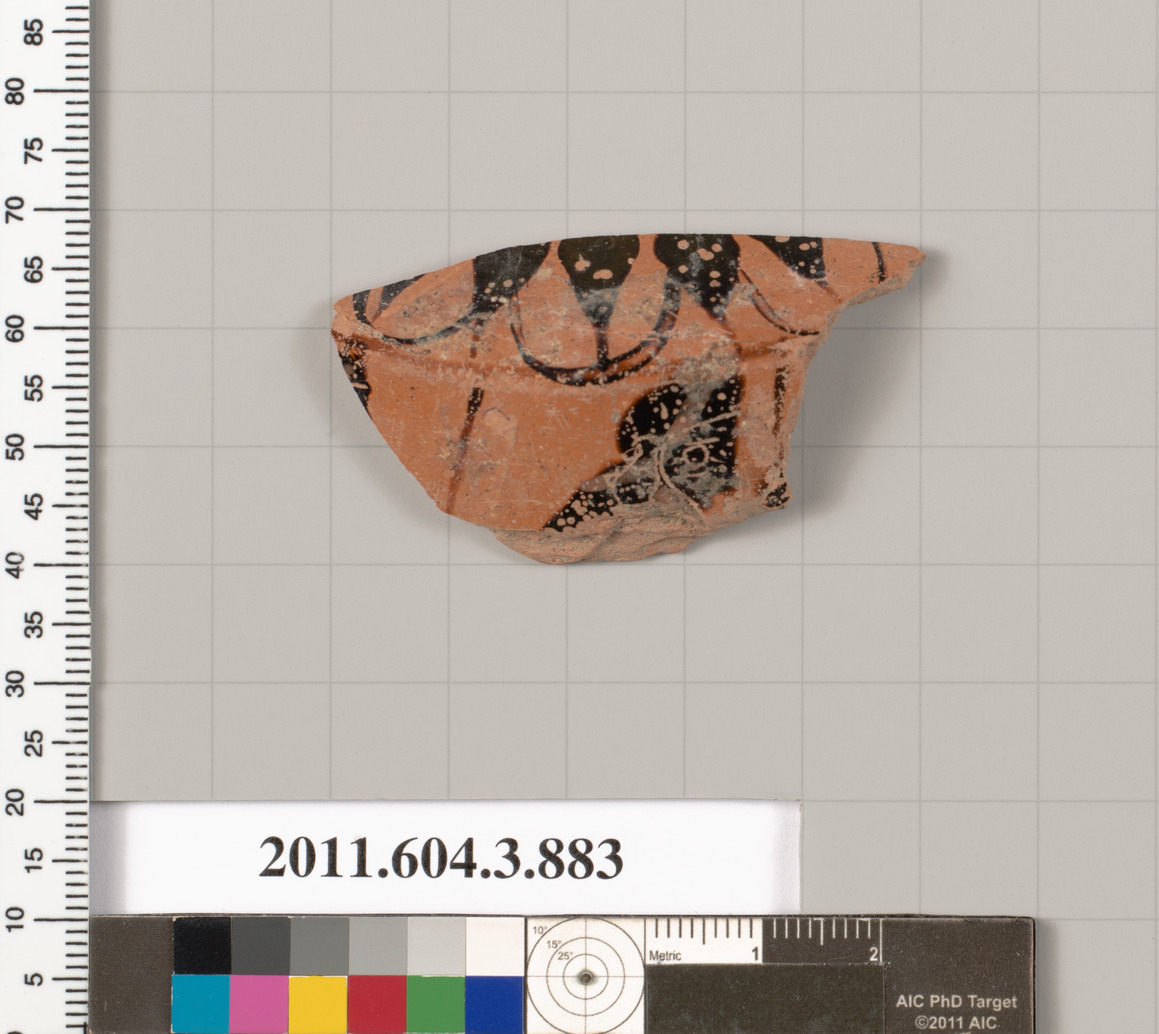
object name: lekythos fragment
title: Terracotta fragment of a lekythos (oil flask)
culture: greek, attic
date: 534-468 BCE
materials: terracotta